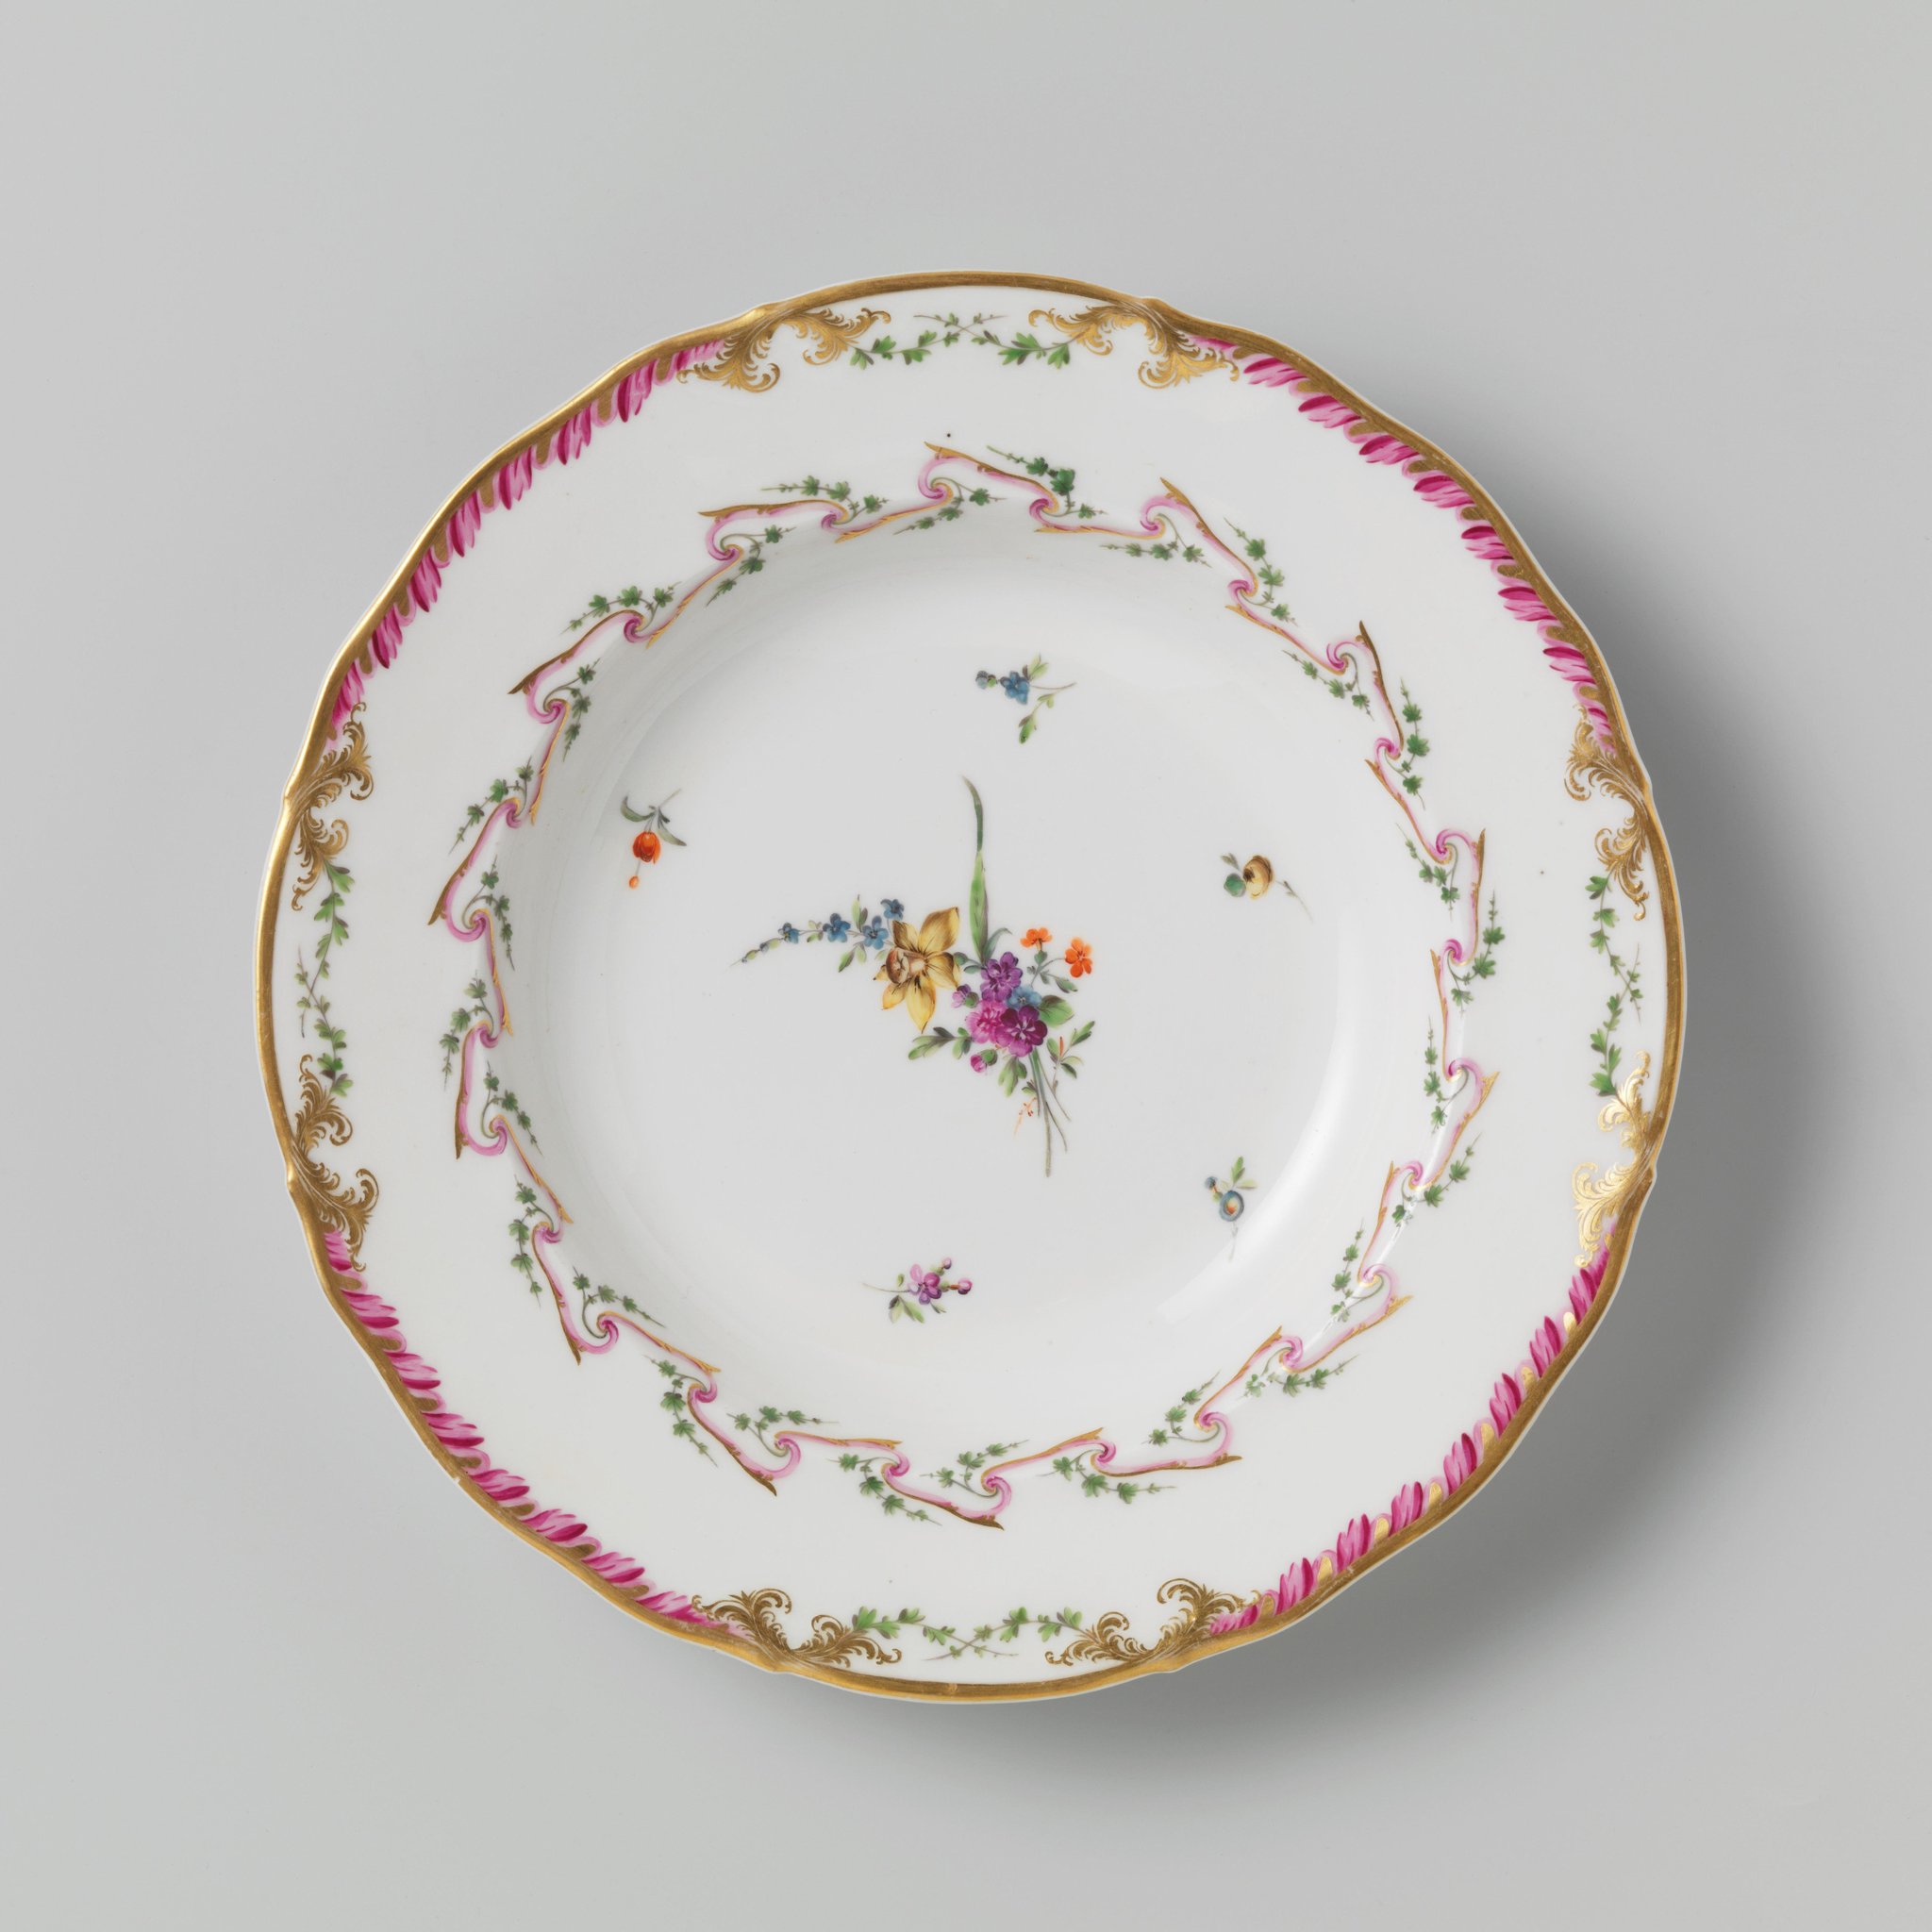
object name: plate dish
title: Bord, diep model, behorend bij een servies met geslingerd lintmotief met bladertakken, bloemboeketten en gestrooide bloemtakken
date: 1780-1820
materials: porcelain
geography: amsterdam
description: Bord, diep model, behorend bij een servies van porselein met geslingerd lintmotief in paars en goud met groene bladertakken, bloemboeketten en gestrooide bloemtakken. Randen lichtgegolfd met decoratie in goud met paars bladmotief waartussen groen gekruist bladmotief. Gemerkt: Mf. DE DIHL ET GUERHARD à PARIS. Serie van elf stuks.